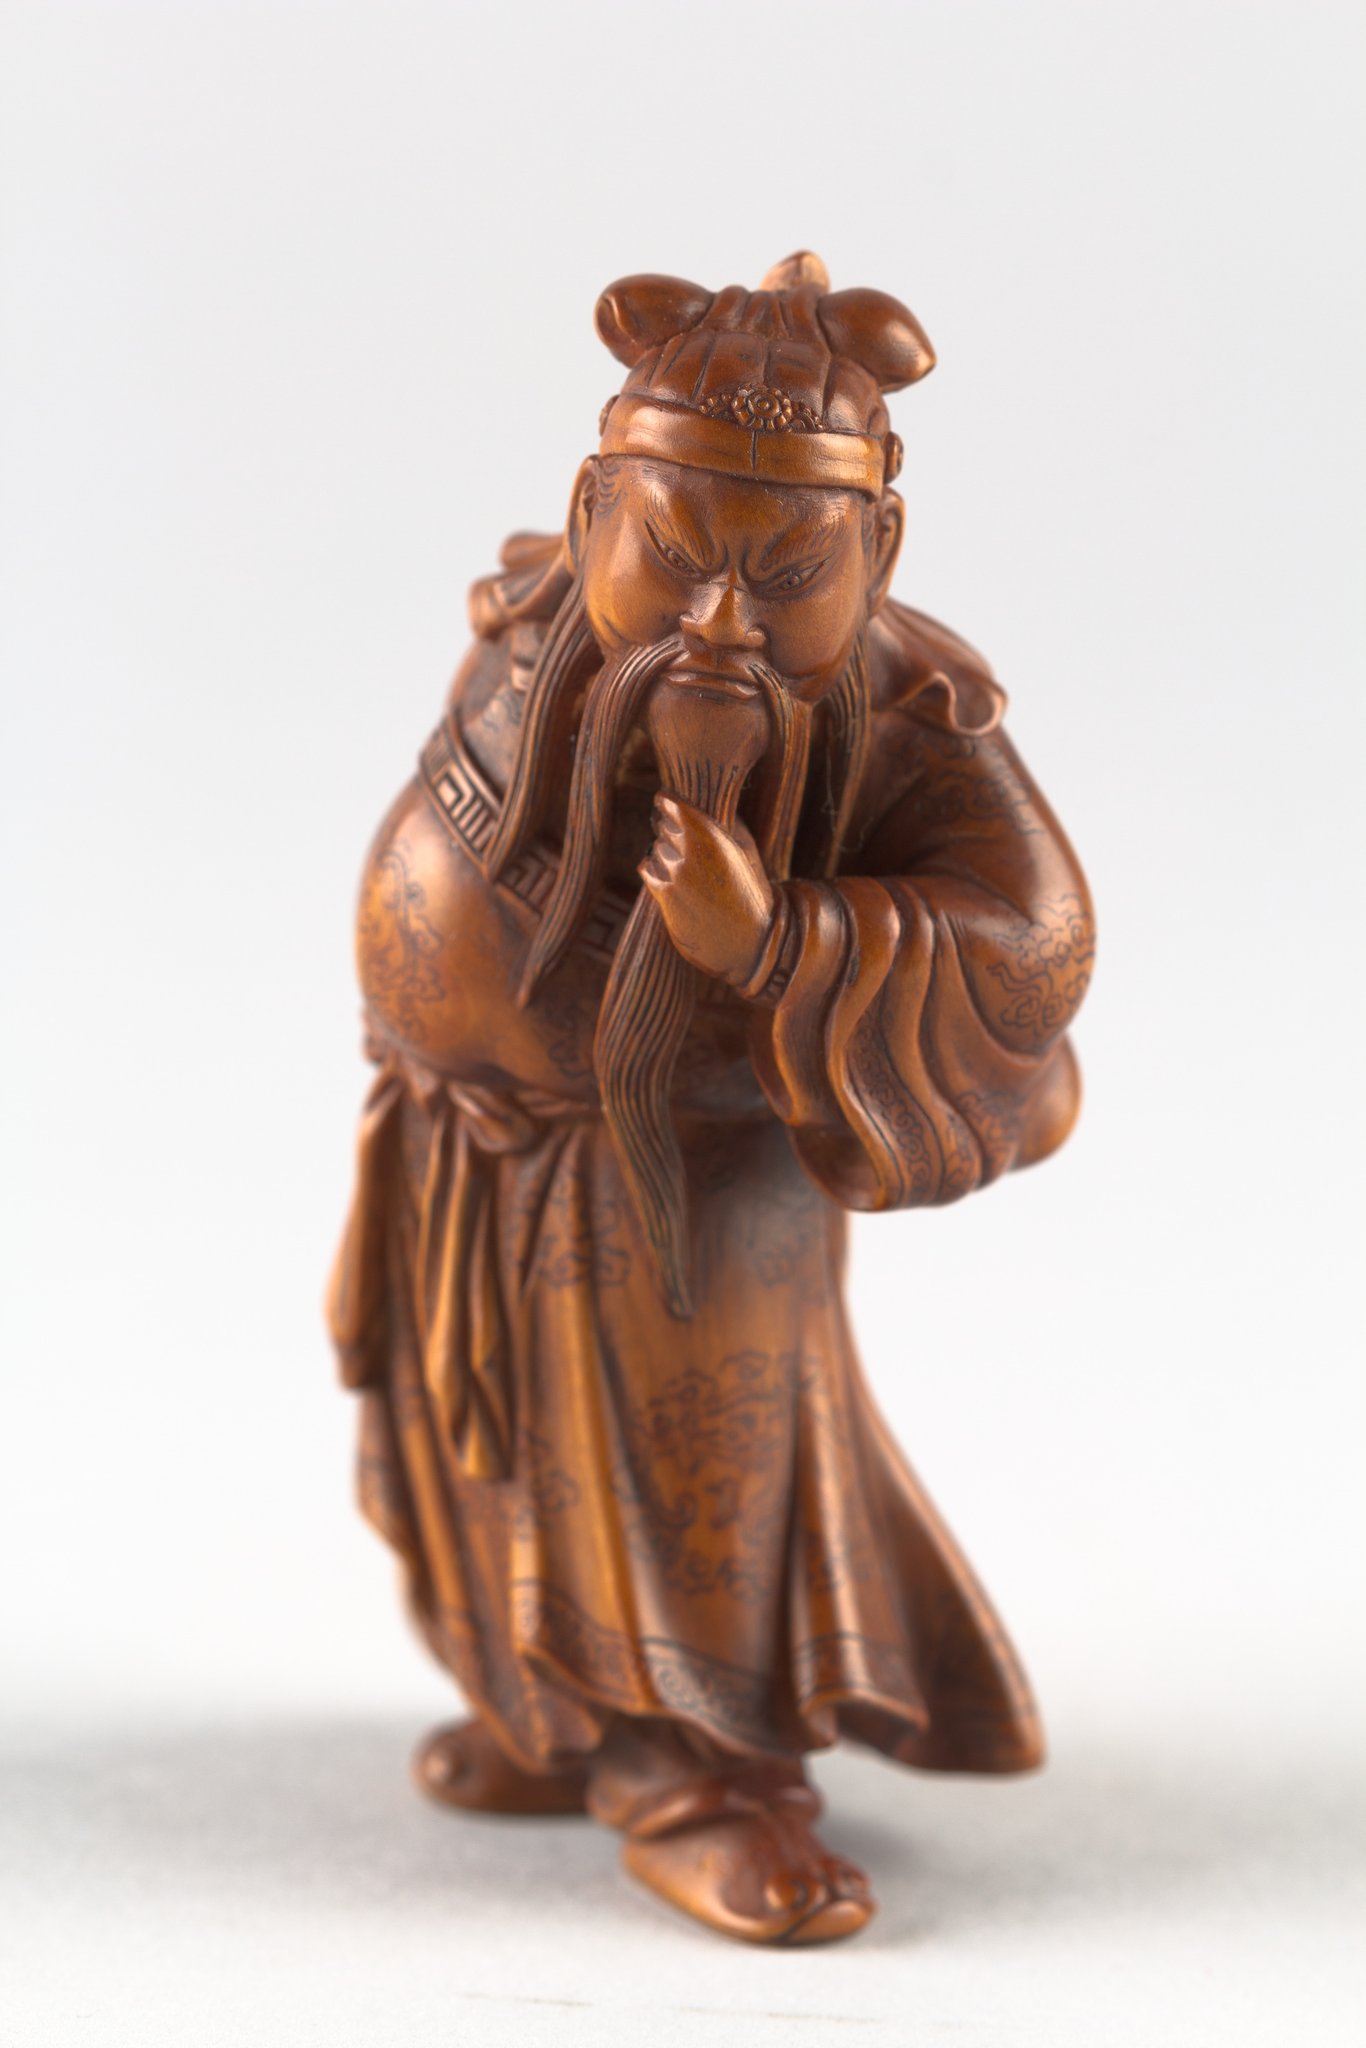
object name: netsuke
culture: japanese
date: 1801-1900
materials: wood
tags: men